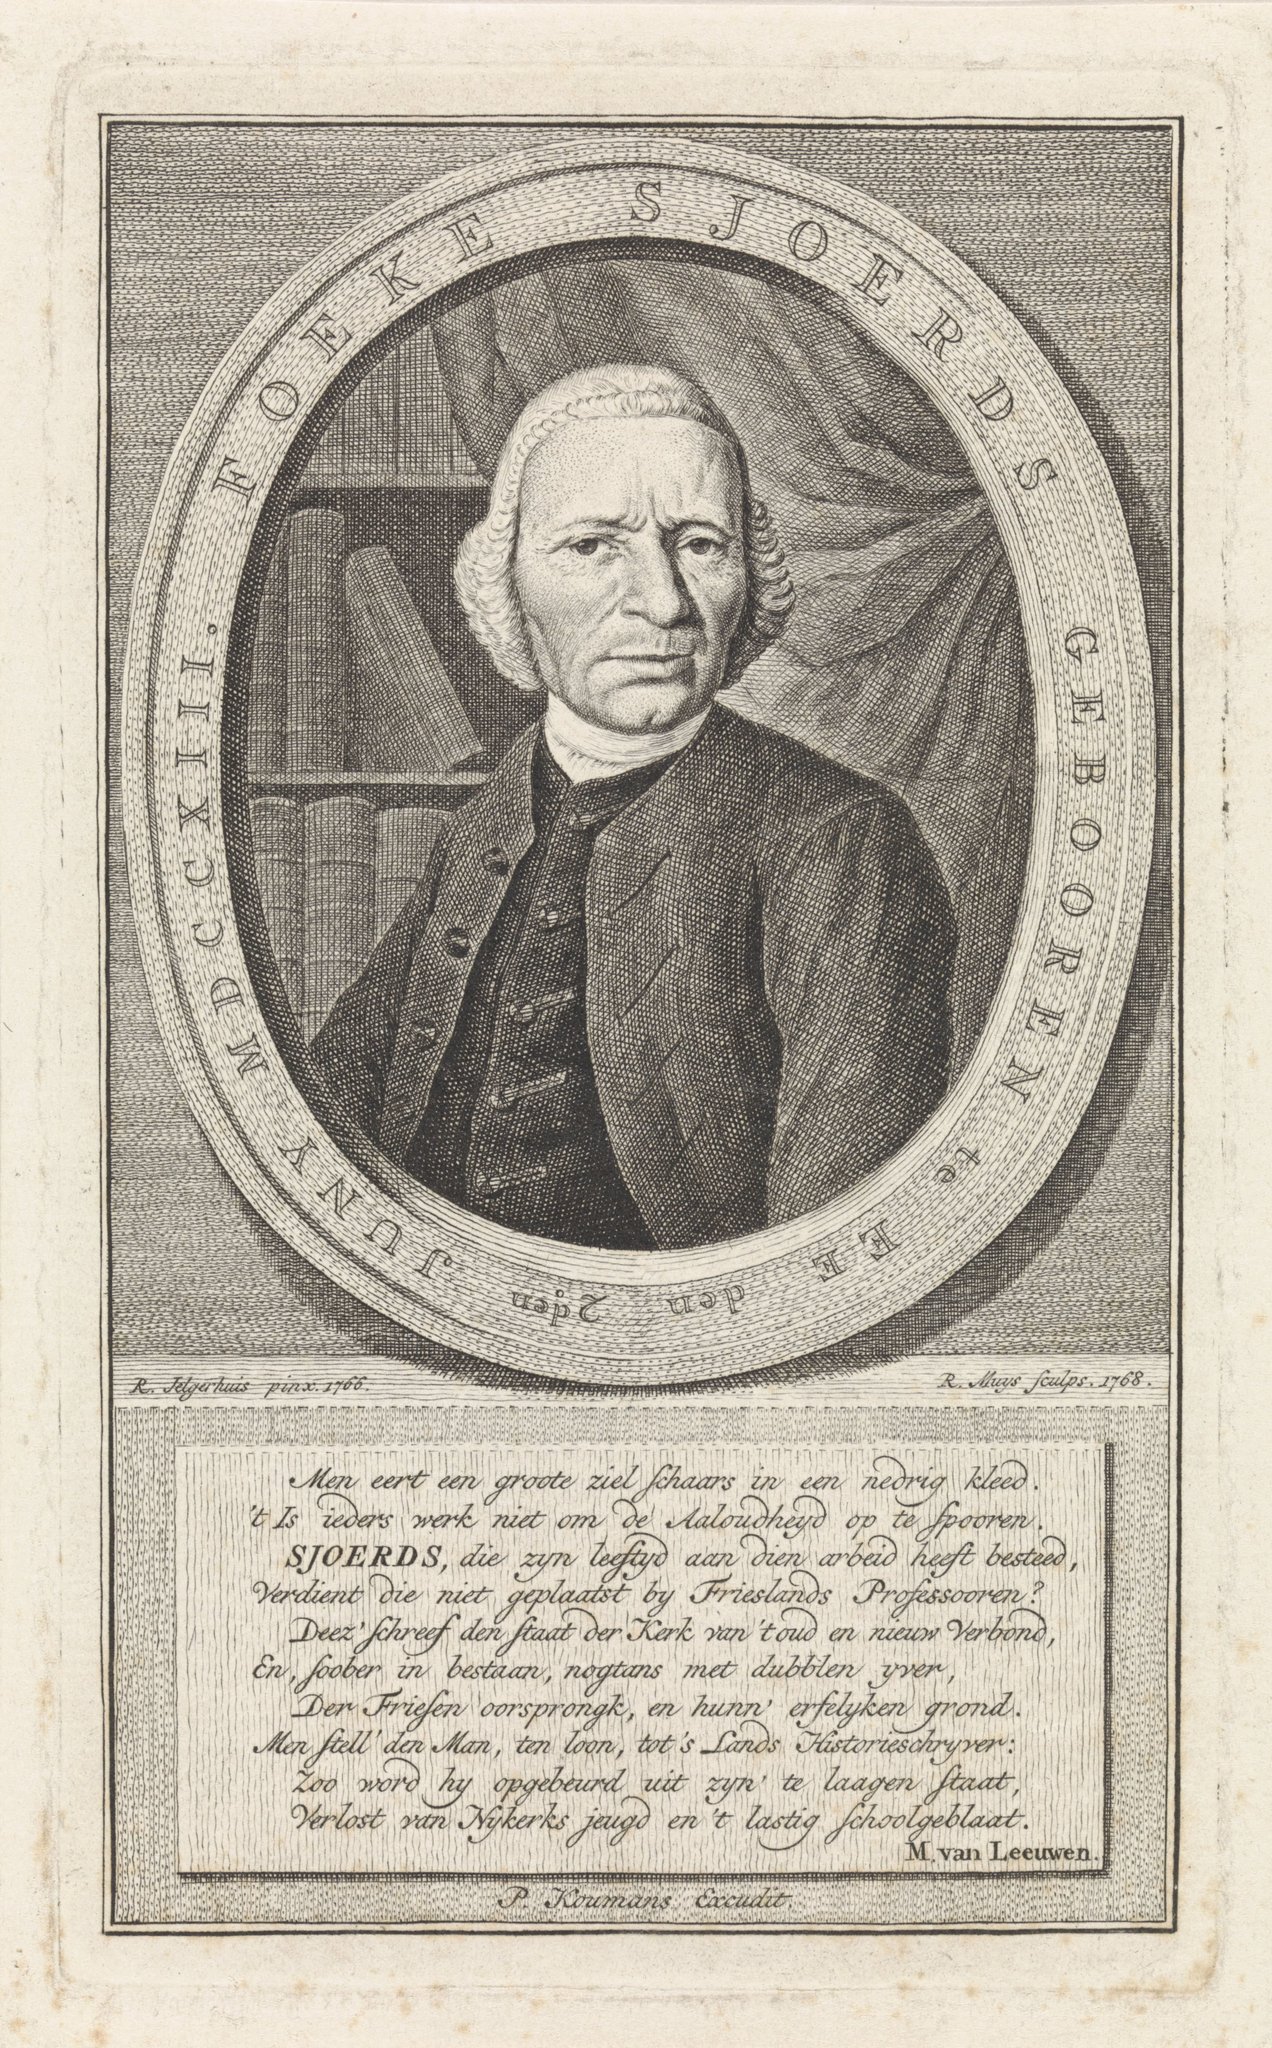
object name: print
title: Portret van Foeke Sjoerds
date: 1768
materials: paper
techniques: engraving, etching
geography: leeuwarden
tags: leraar, historicus, foeke sjoerds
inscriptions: collector's mark: Lugt 2228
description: Foeke Sjoerds voor een boekenkast. Buste naar links in ovaal met randschrift. Onderaan in de marge een tienregelig vers in het Nederlands.